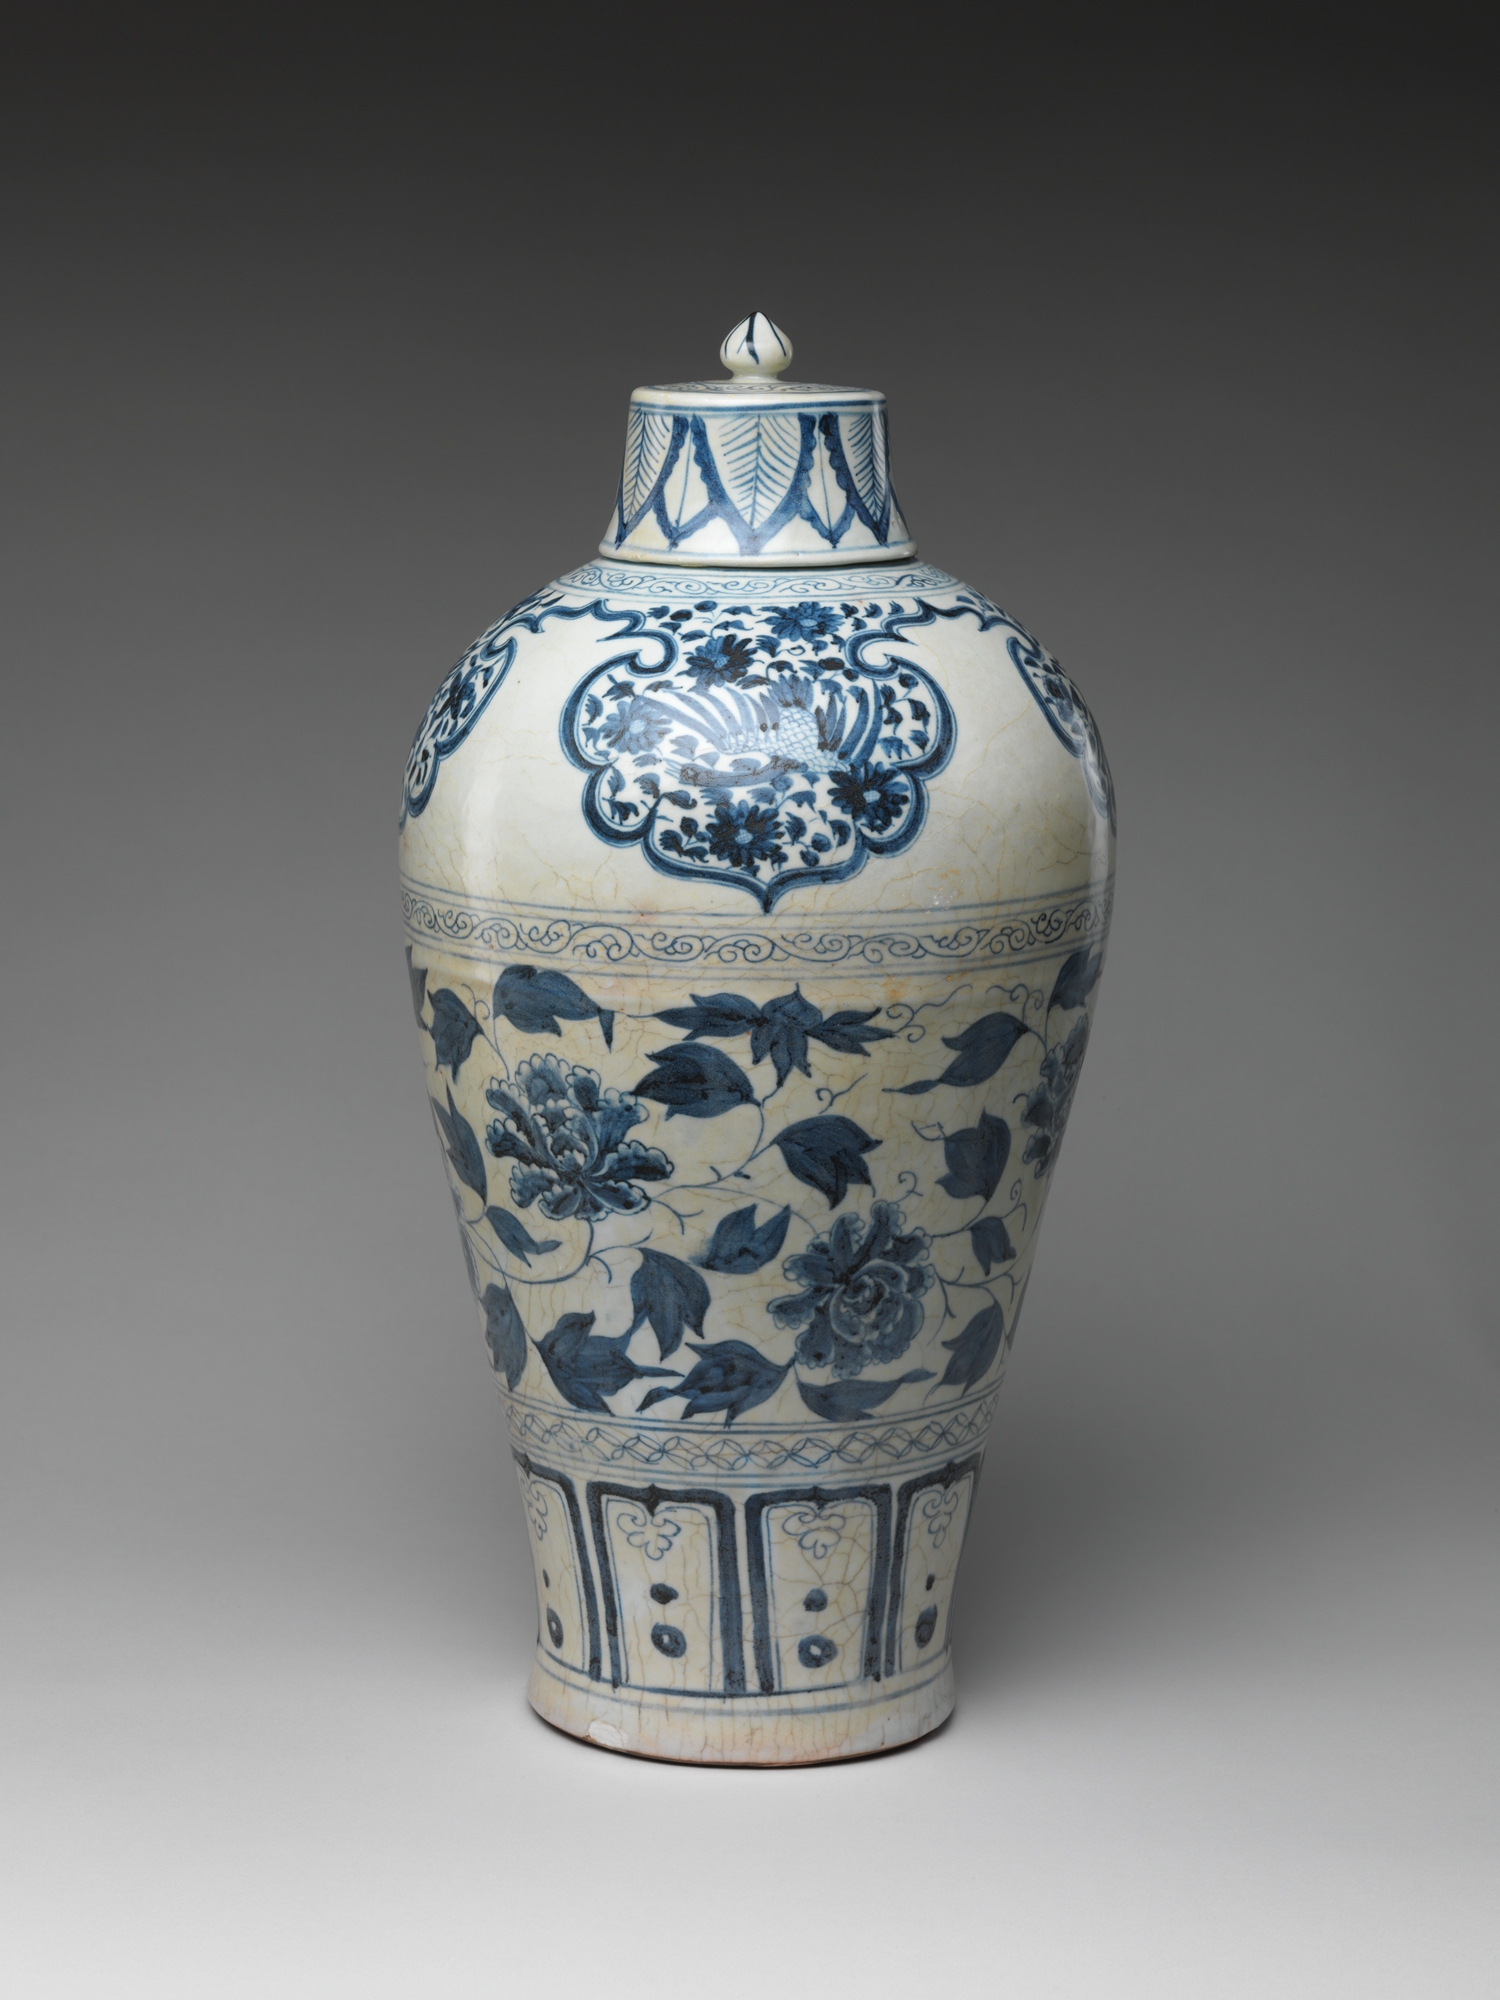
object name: bottle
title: Bottle with Peony Scroll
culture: chinese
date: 1334-1366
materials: cobalt, glaze, porcelain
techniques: painting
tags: peonies,leaves